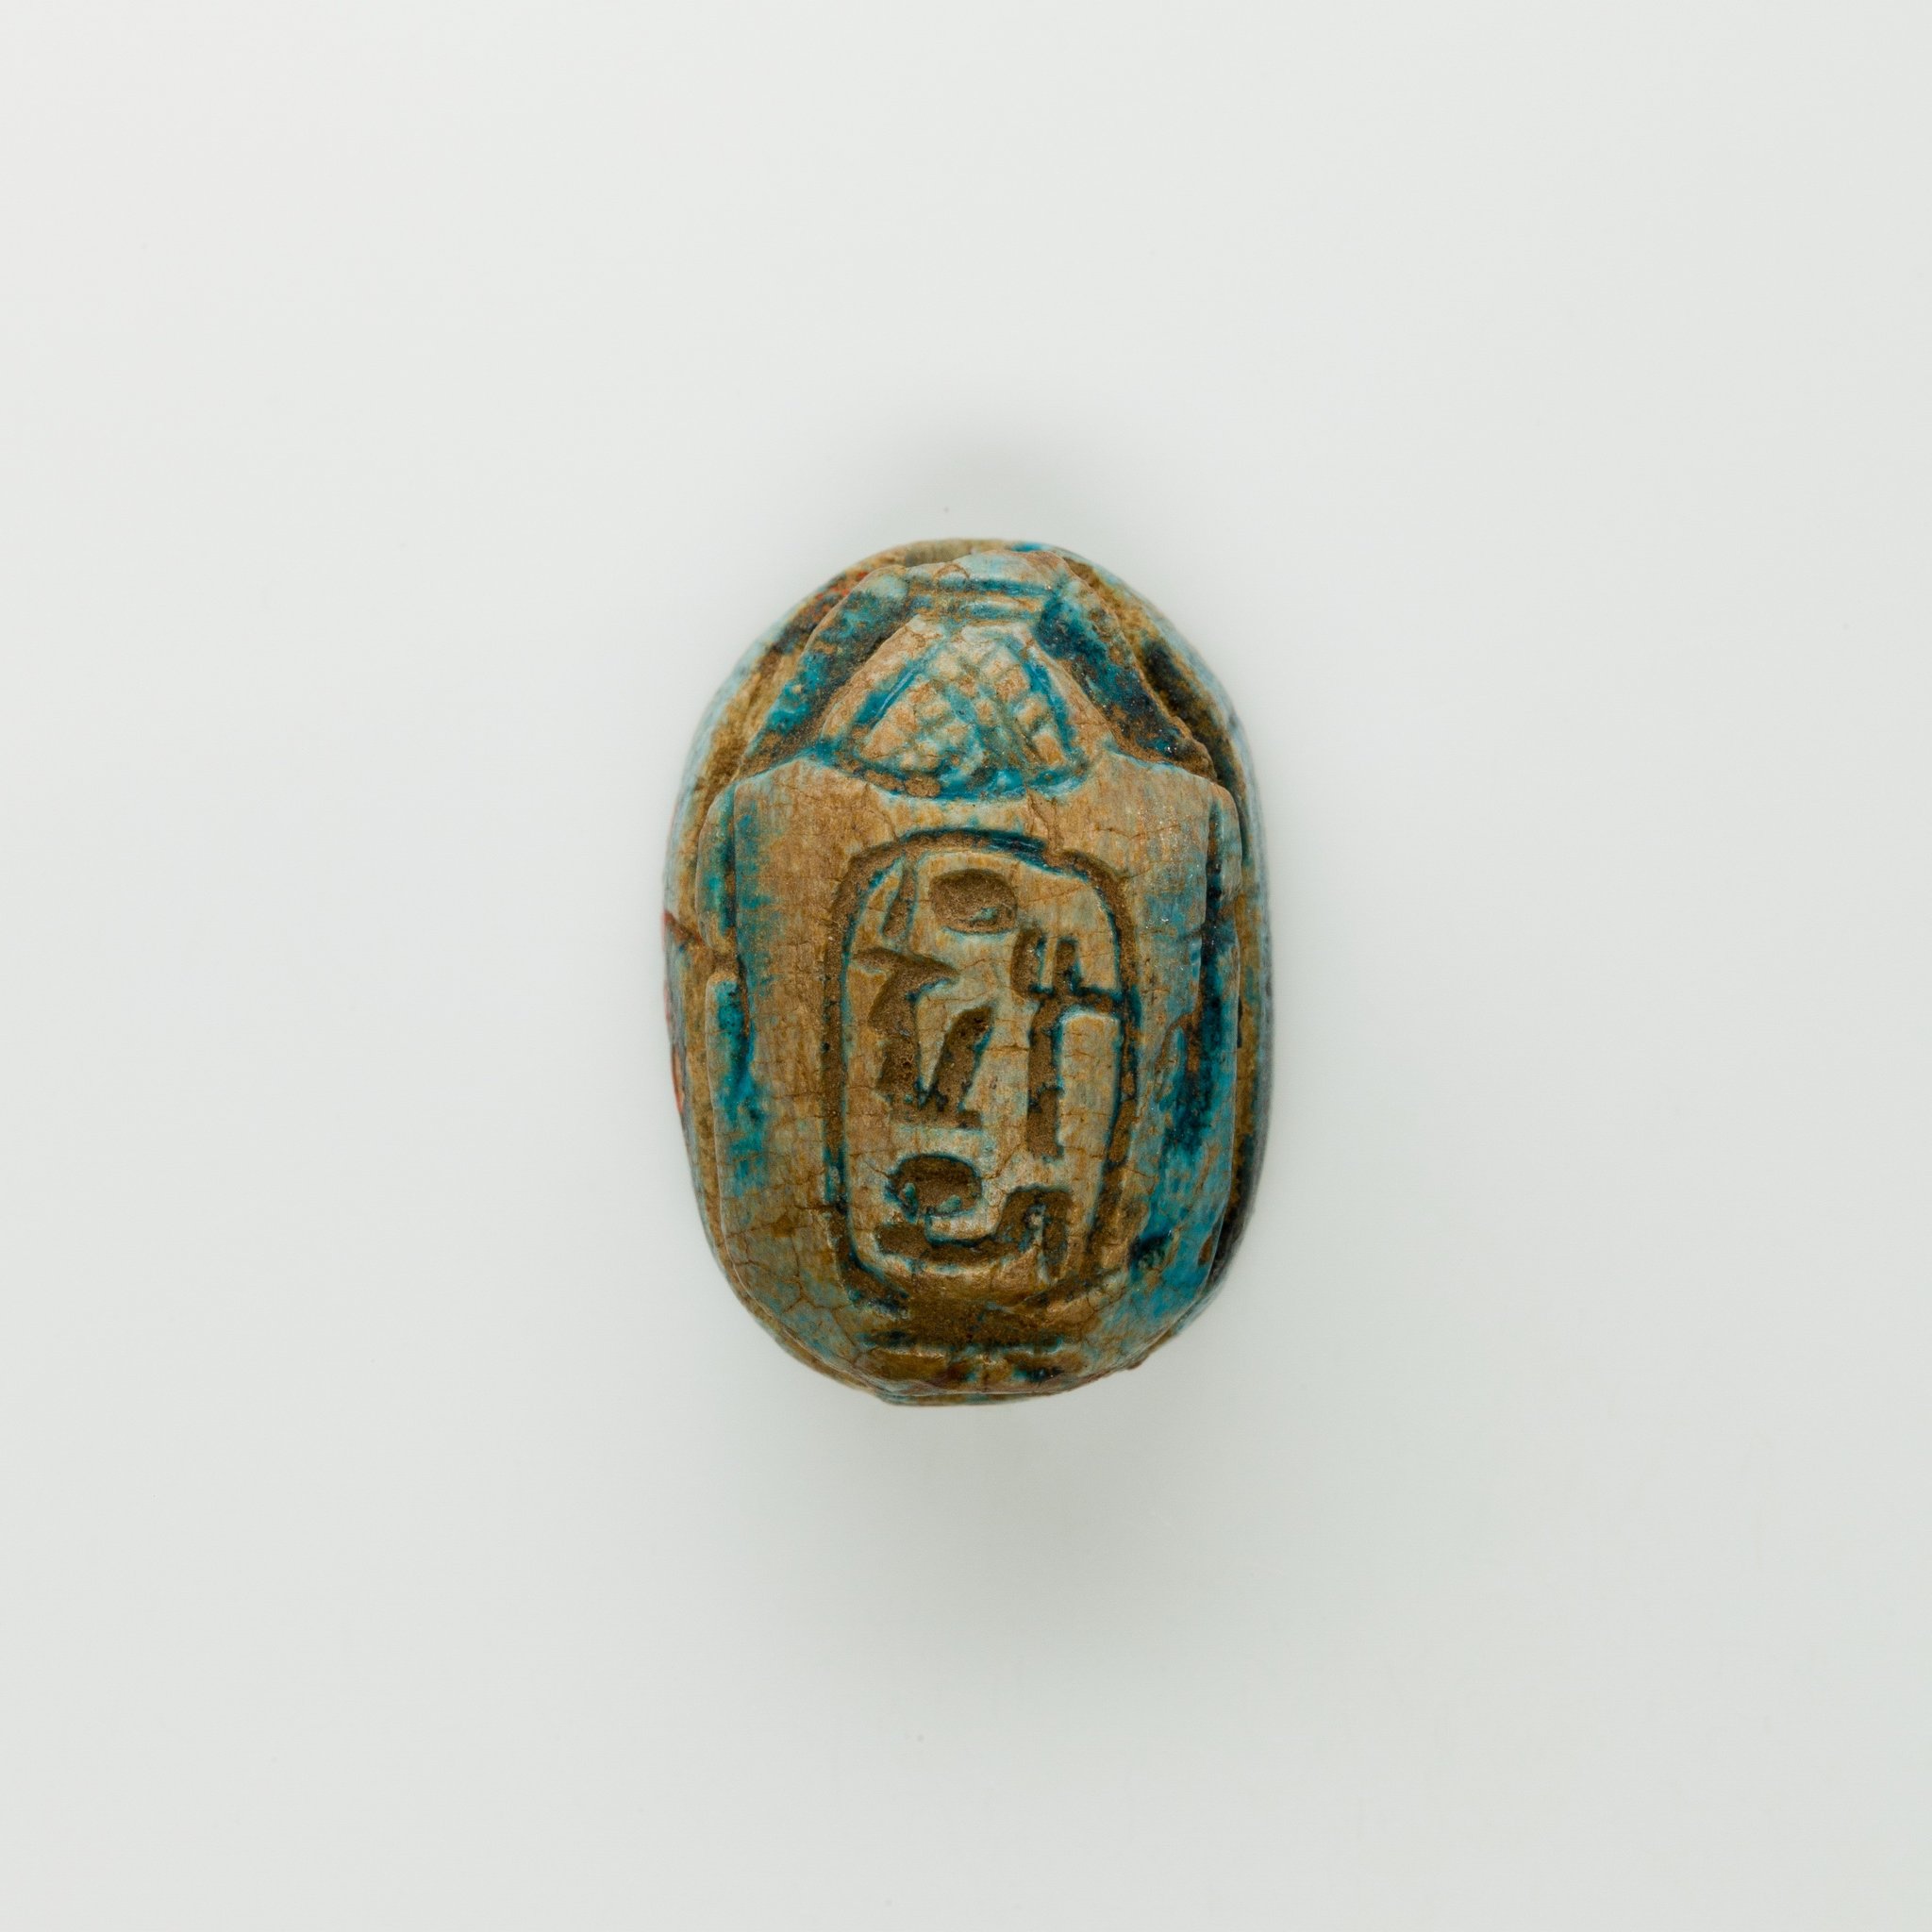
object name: scarab, ramesses ii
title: Scarab of Ramesses II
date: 1295-1070 BCE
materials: stone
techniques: glazing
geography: egypt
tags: hieroglyphs,scarabs